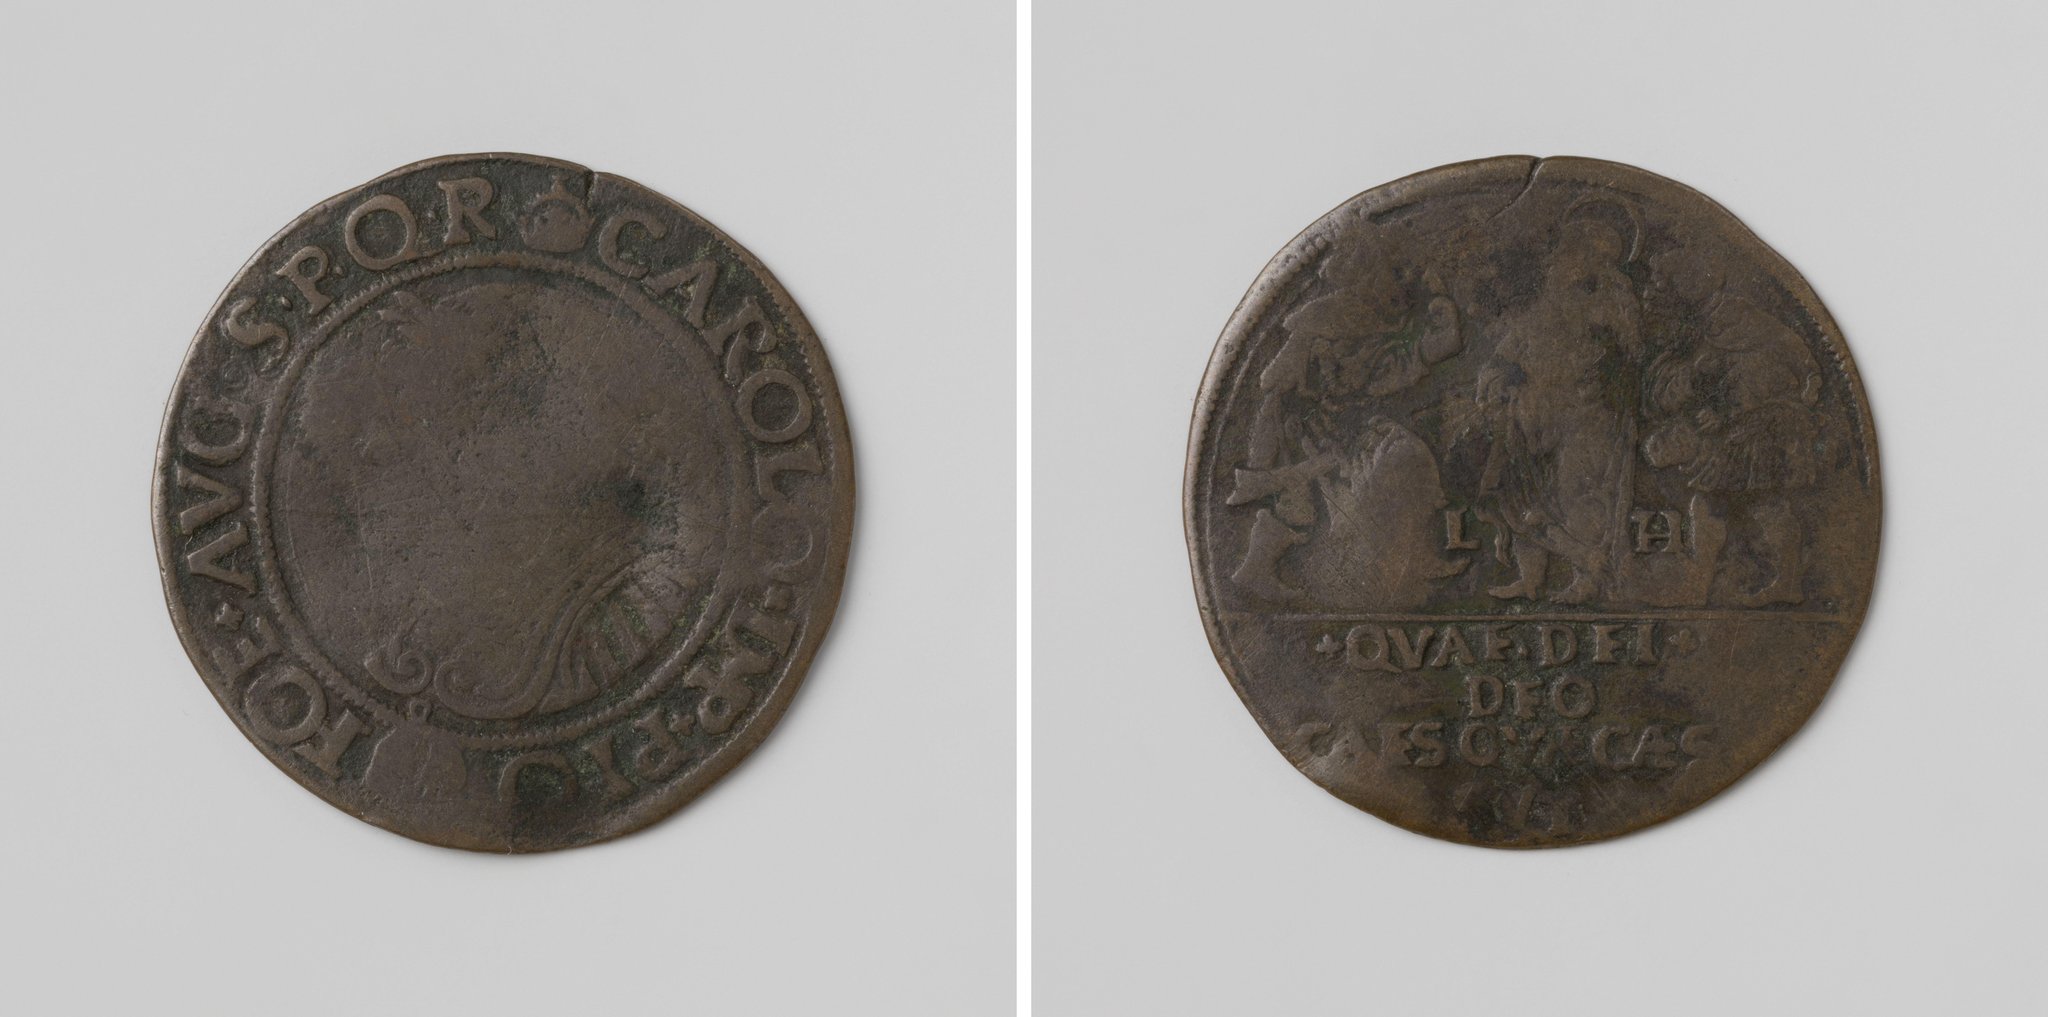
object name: jeton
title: Bevrediging van Gent, rekenpenning geslagen ter ere van Karel V, Duits keizer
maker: Anonymous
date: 1540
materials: copper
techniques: striking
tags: ghent, charles v (holy roman emperor and king of spain)